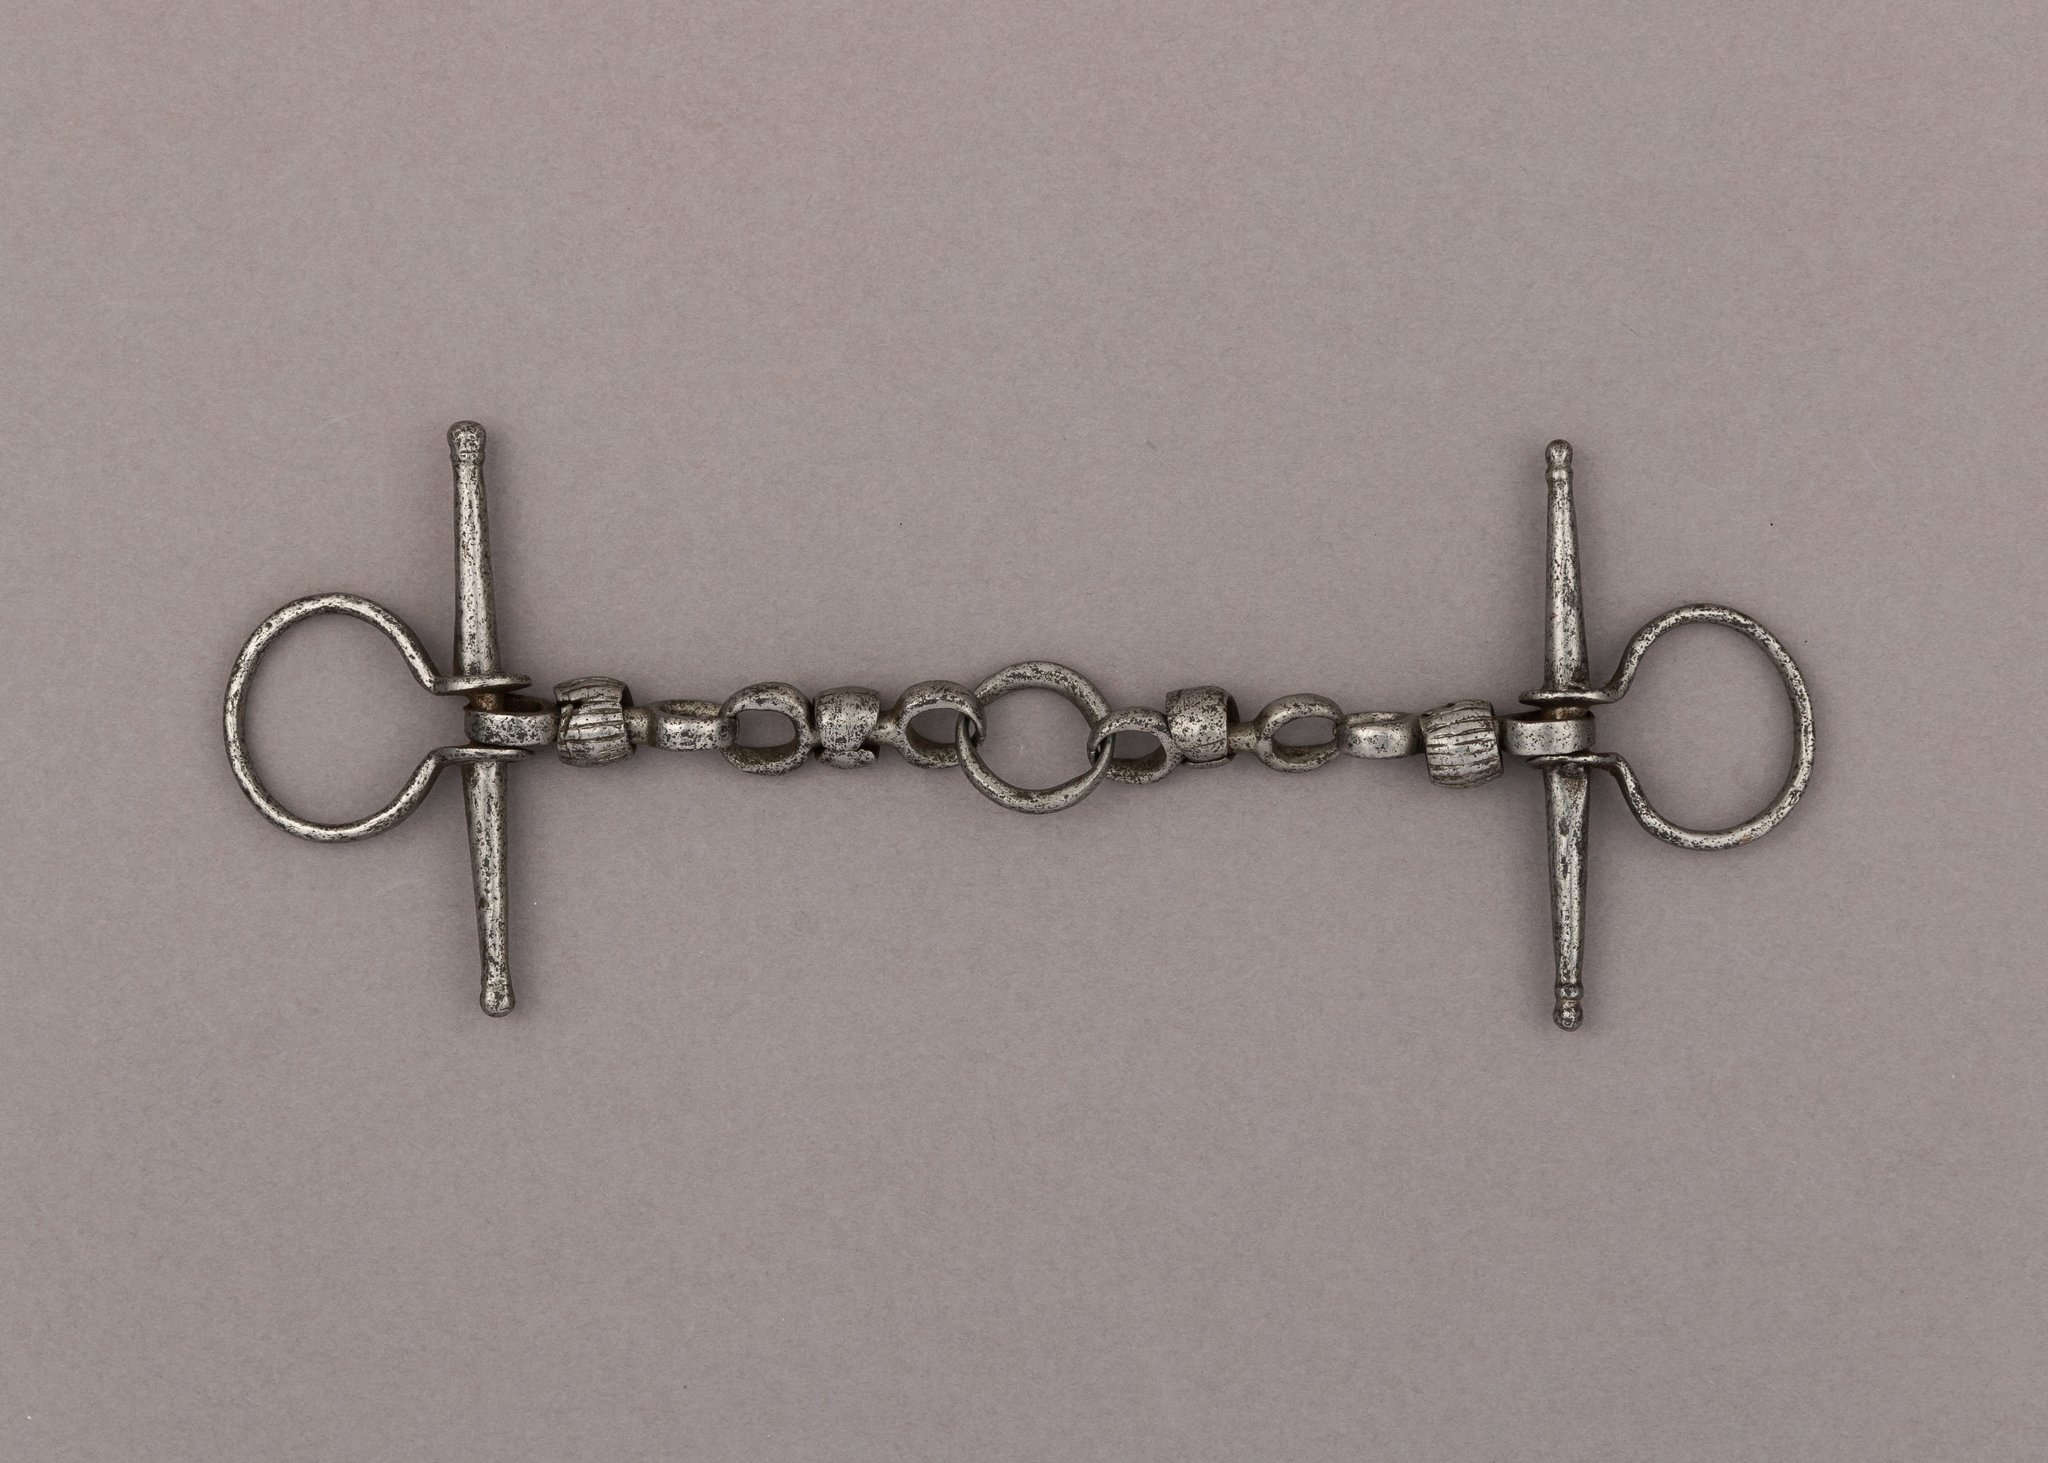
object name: bit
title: Snaffle Bit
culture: german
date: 1567-1700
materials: metal alloy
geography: germany